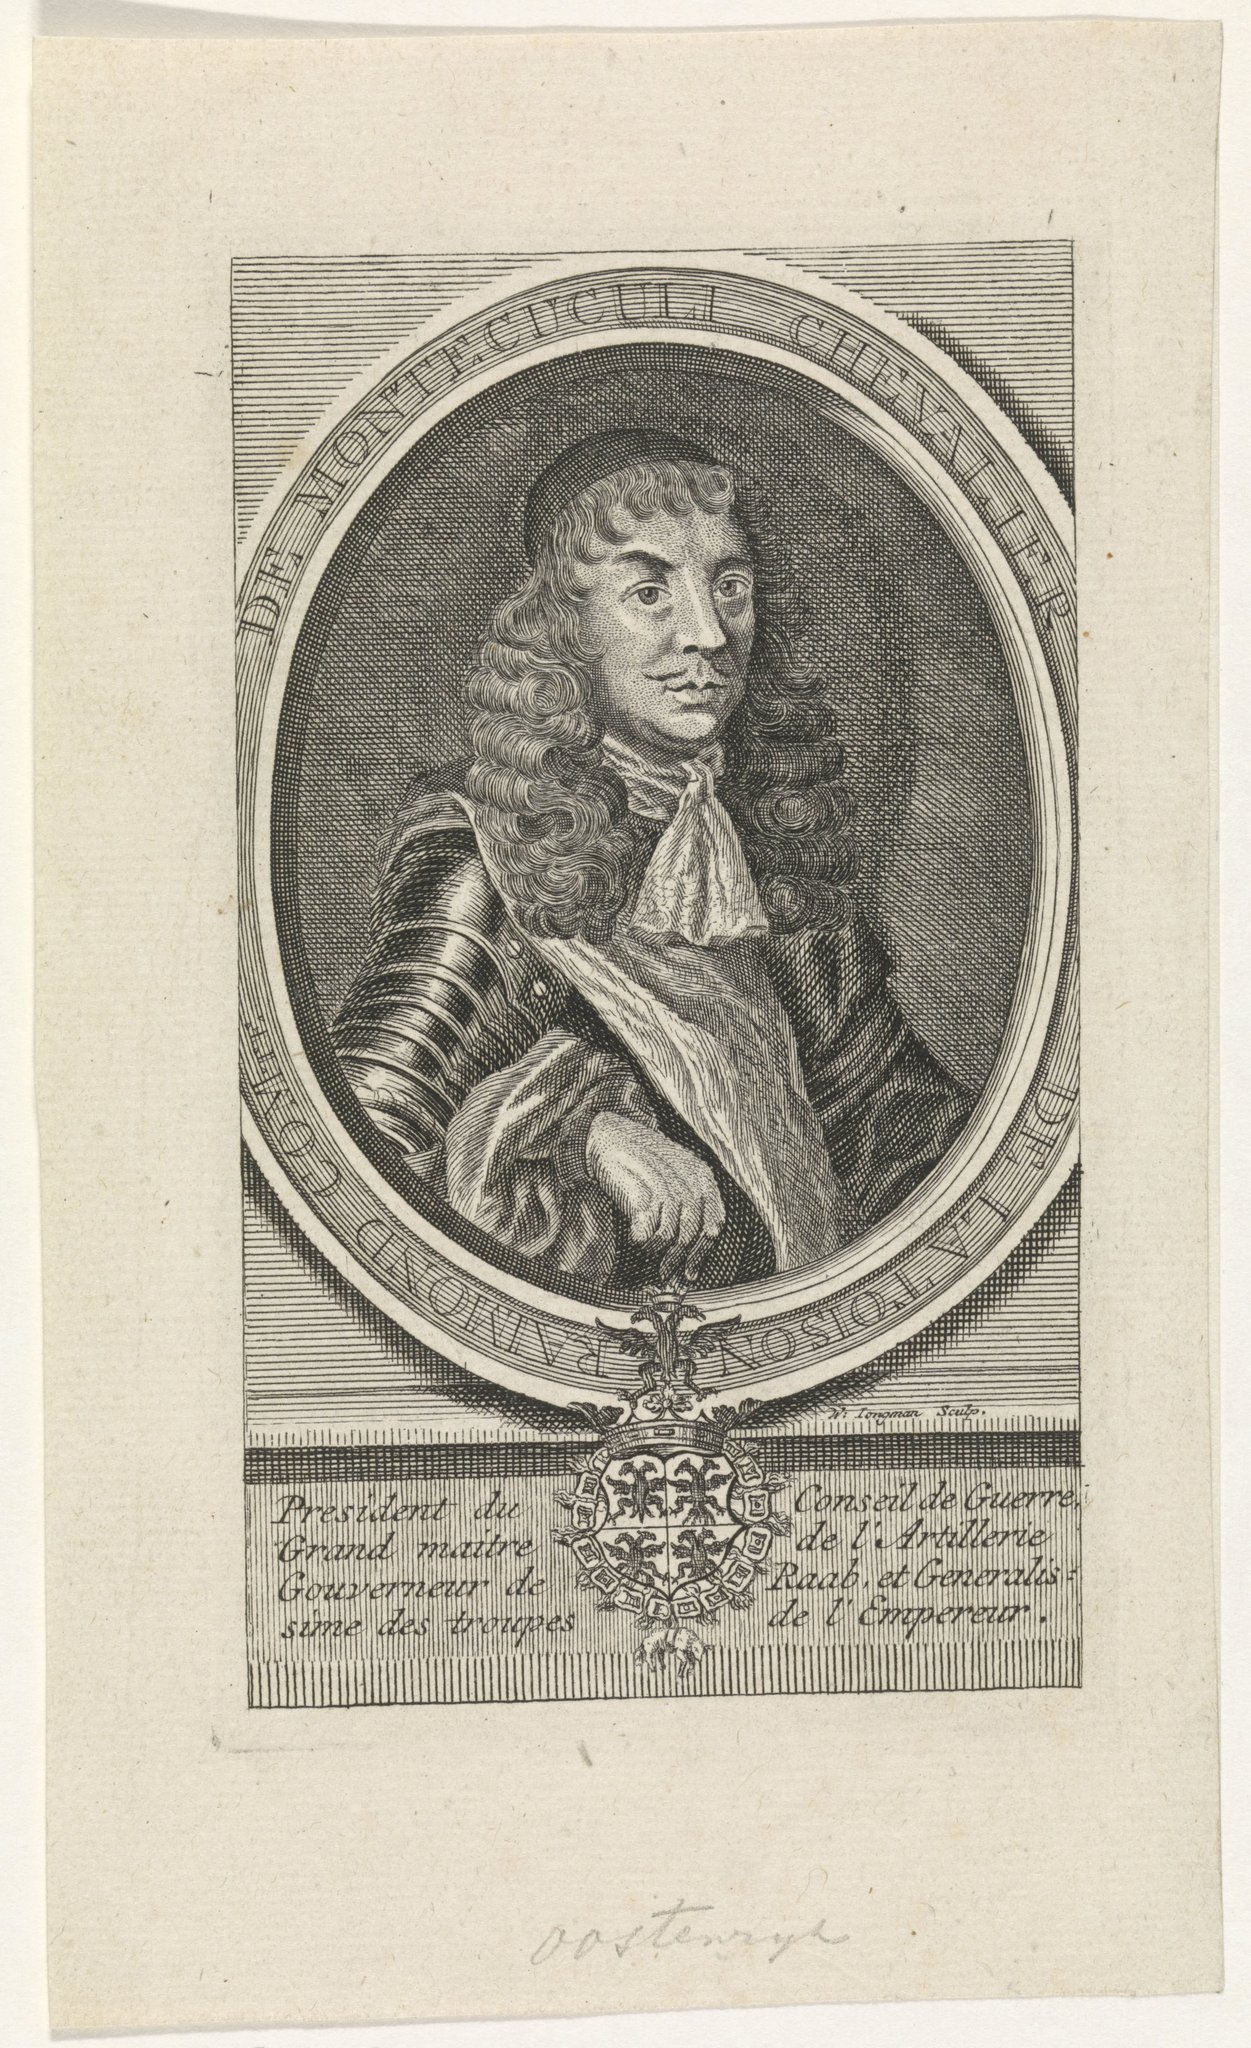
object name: print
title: Portret van Raimondo, graaf van Montecuccoli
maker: wouter jongman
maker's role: print maker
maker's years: -1753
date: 1712-1744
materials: paper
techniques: engraving, etching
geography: amsterdam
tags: emilia-romagna, linz, staatsman, veldheer, veldmaarschalk, raimondo montecuccoli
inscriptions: collector's mark: Lugt 2228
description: Busteportret van Raimondo, graaf van Montecuccoli. Hij draagt een harnas, sjaal en kalot. Het portret is gevat in een ovale omlijsting met een randschrift in het Frans en het wapenschild van de geportretteerde. In de marge een vierregelig onderschrift in het Frans.